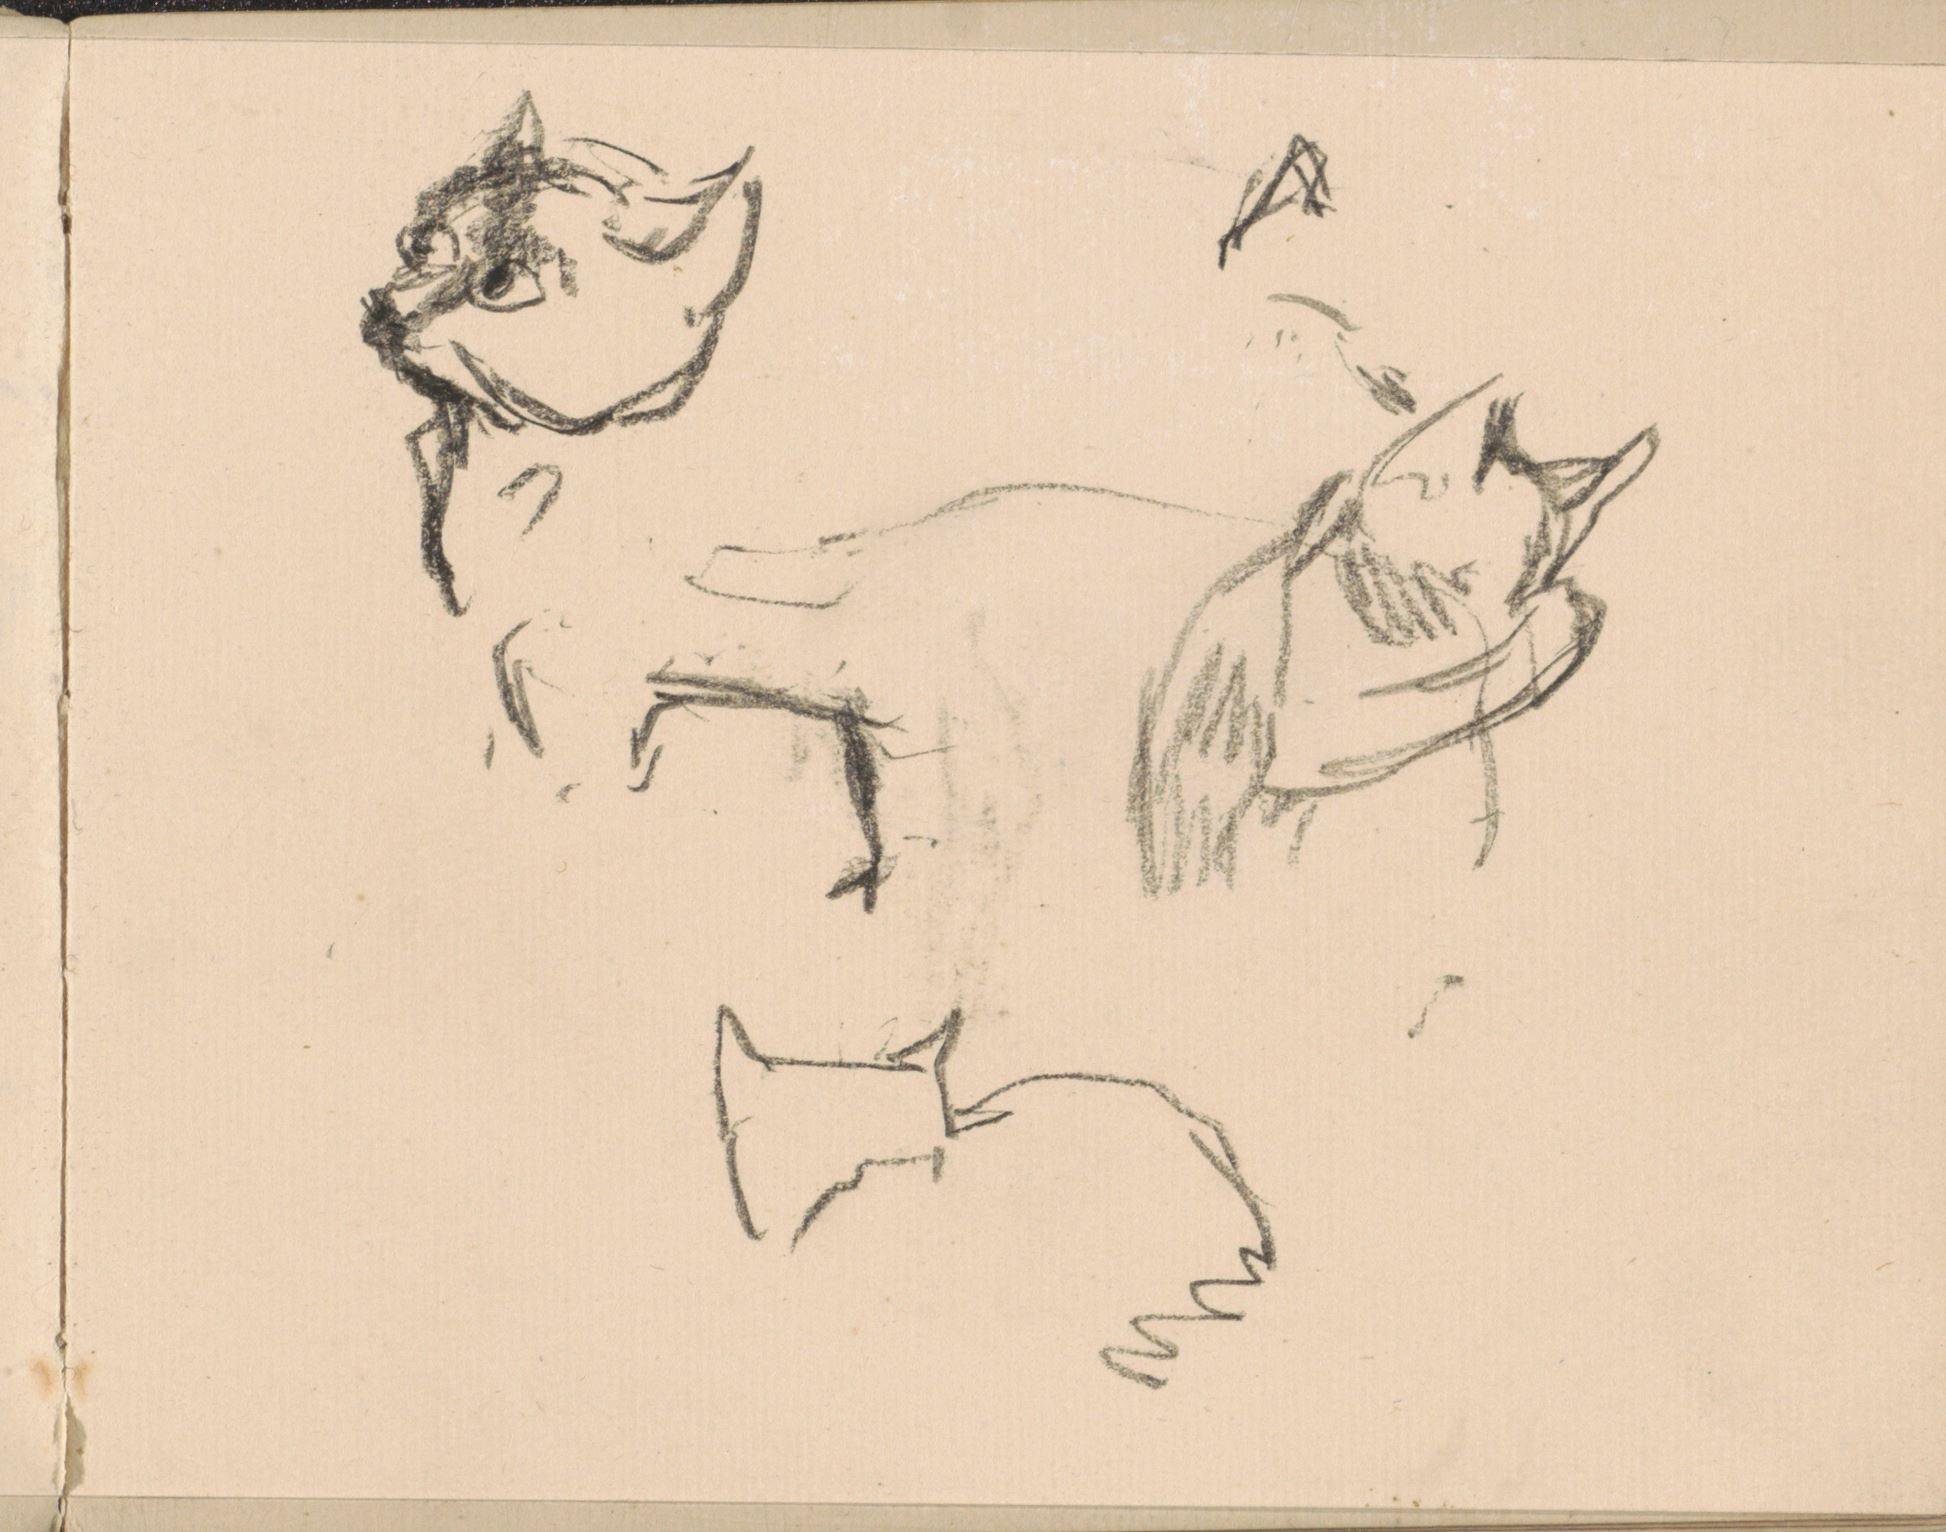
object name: sketchbook leaf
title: Katten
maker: george hendrik breitner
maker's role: draughtsman, painter, print maker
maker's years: 1857-1923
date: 1885-1898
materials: chalk, paper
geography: amsterdam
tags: cat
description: Pagina 28 uit een schetsboek met 32 bladen.